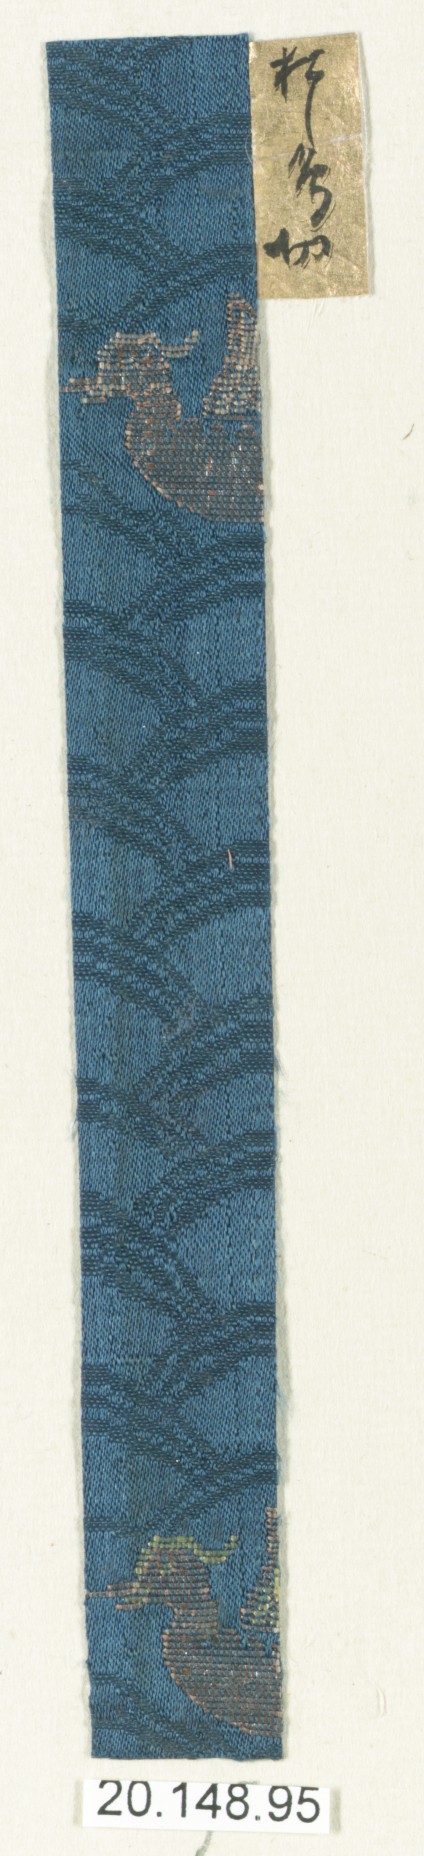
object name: piece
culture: japanese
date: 1601-1700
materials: silk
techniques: compound weave